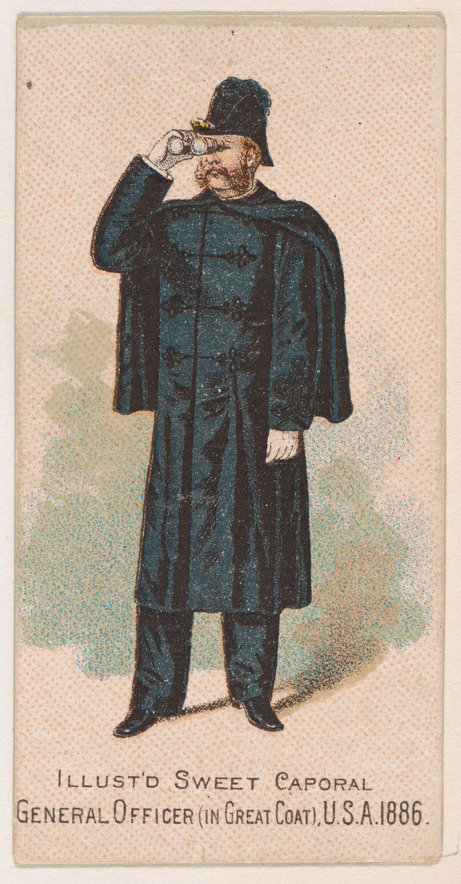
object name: print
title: General Officer in Great Coat, United States Army, 1886, from the Military Series (N224) issued by Kinney Tobacco Company to promote Sweet Caporal Cigarettes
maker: kinney brothers tobacco company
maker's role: publisher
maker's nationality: american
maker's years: 1869-2011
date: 1888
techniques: color lithograph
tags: military,men